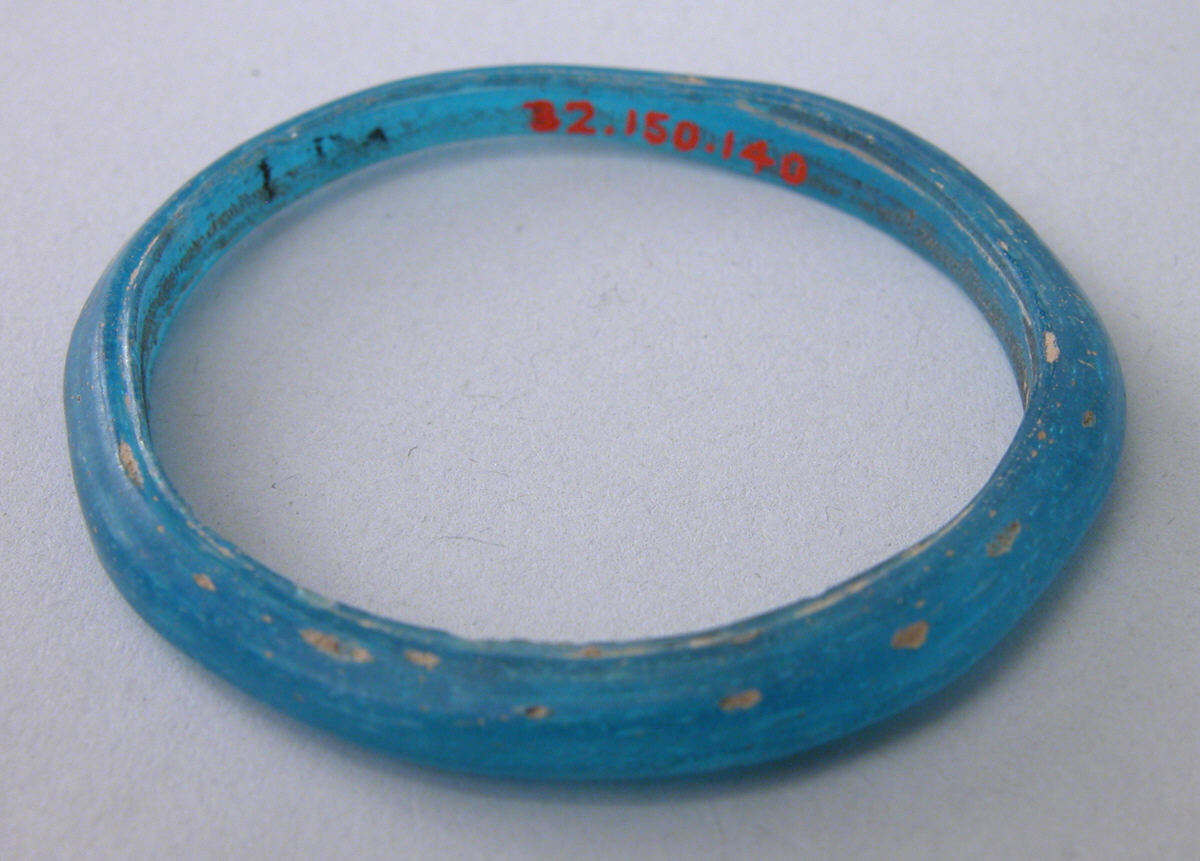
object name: bracelet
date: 601-800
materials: glass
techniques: tooling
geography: iraq